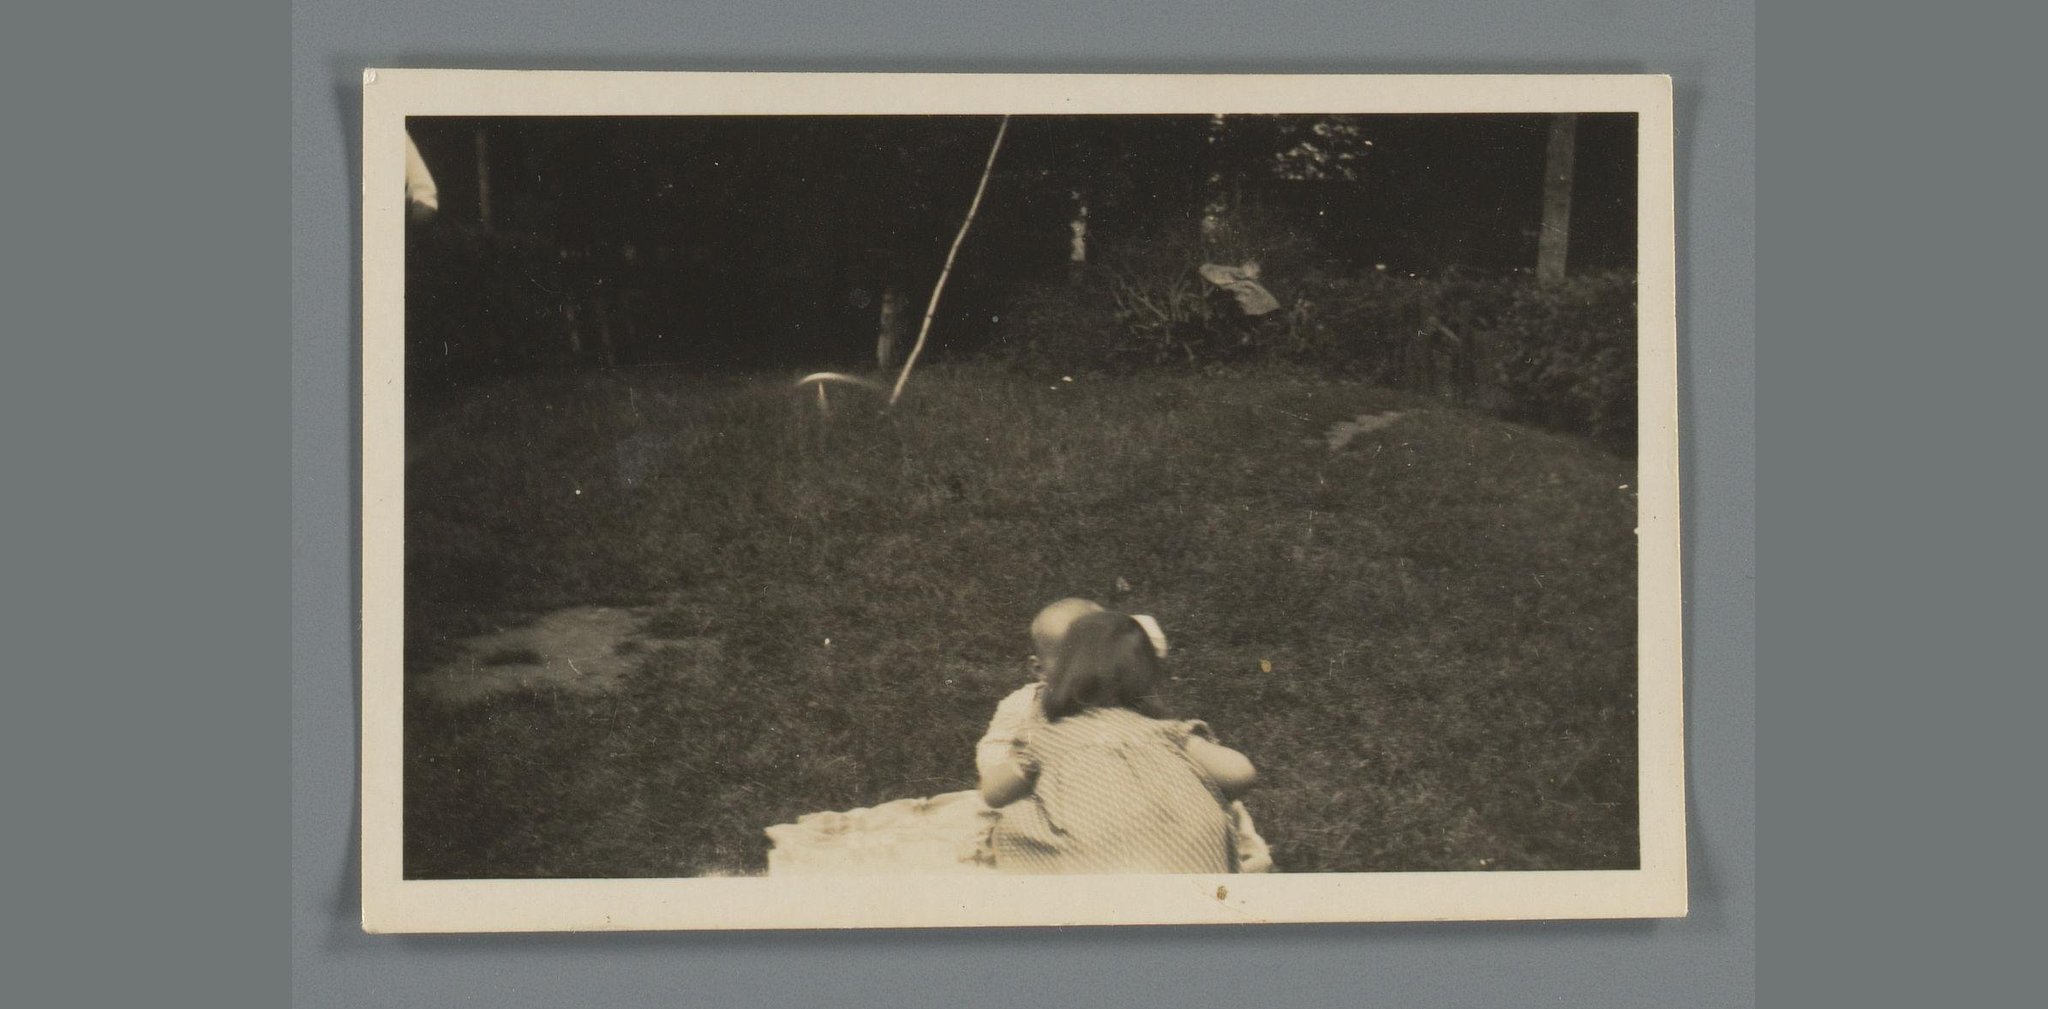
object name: photograph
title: Twee kleine kinderen op een grasveld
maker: Anonymous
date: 1920-1950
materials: paper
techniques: gelatin silver print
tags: garden, child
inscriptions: inscription: ‘A’